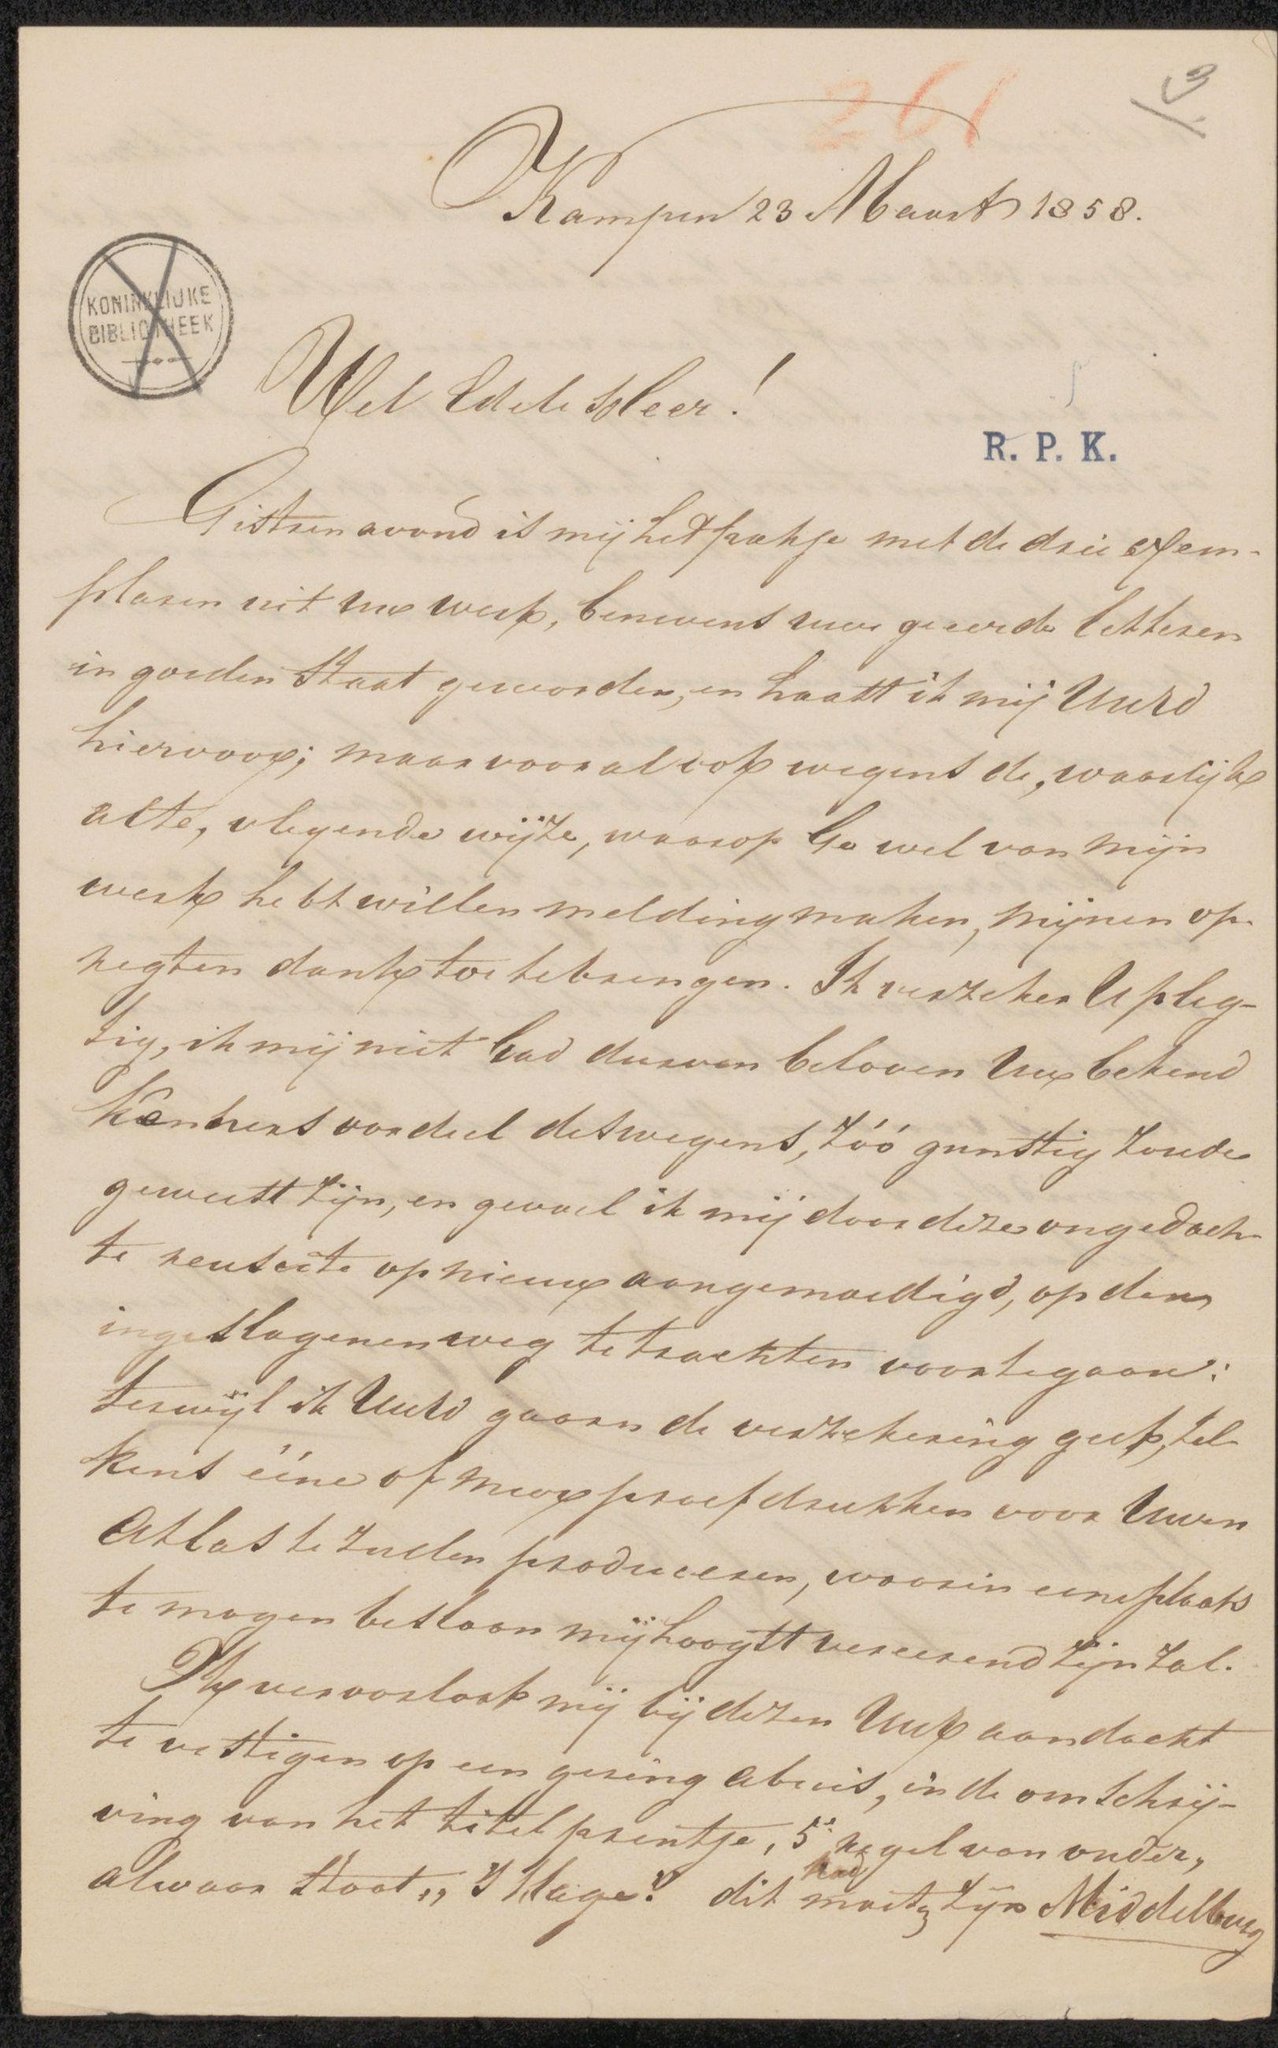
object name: letter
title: Brief aan Christiaan Kramm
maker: jacobus cornelis gaal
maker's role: print maker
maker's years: 1796-1866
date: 1858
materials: ink, paper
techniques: pen, writing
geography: kampen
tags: utrecht, print maker, draughtsman, christiaan kramm, printed matter, zeeland, middelburg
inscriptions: collector's mark: Lugt 2233, collector's mark: ‘KONINKLIJKE BIBLIOTHEEK’